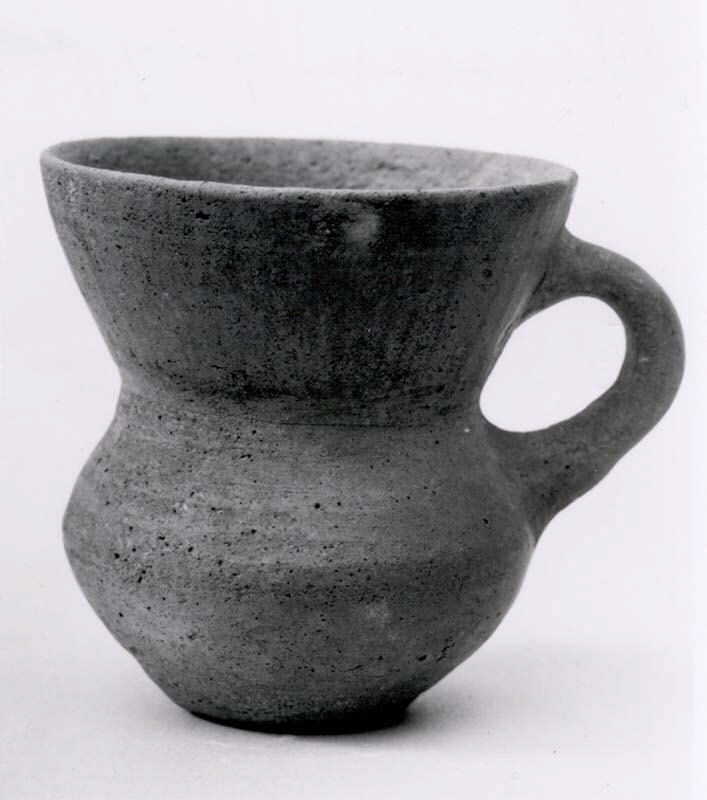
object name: jar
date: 2000-1001 BCE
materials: ceramic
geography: iran